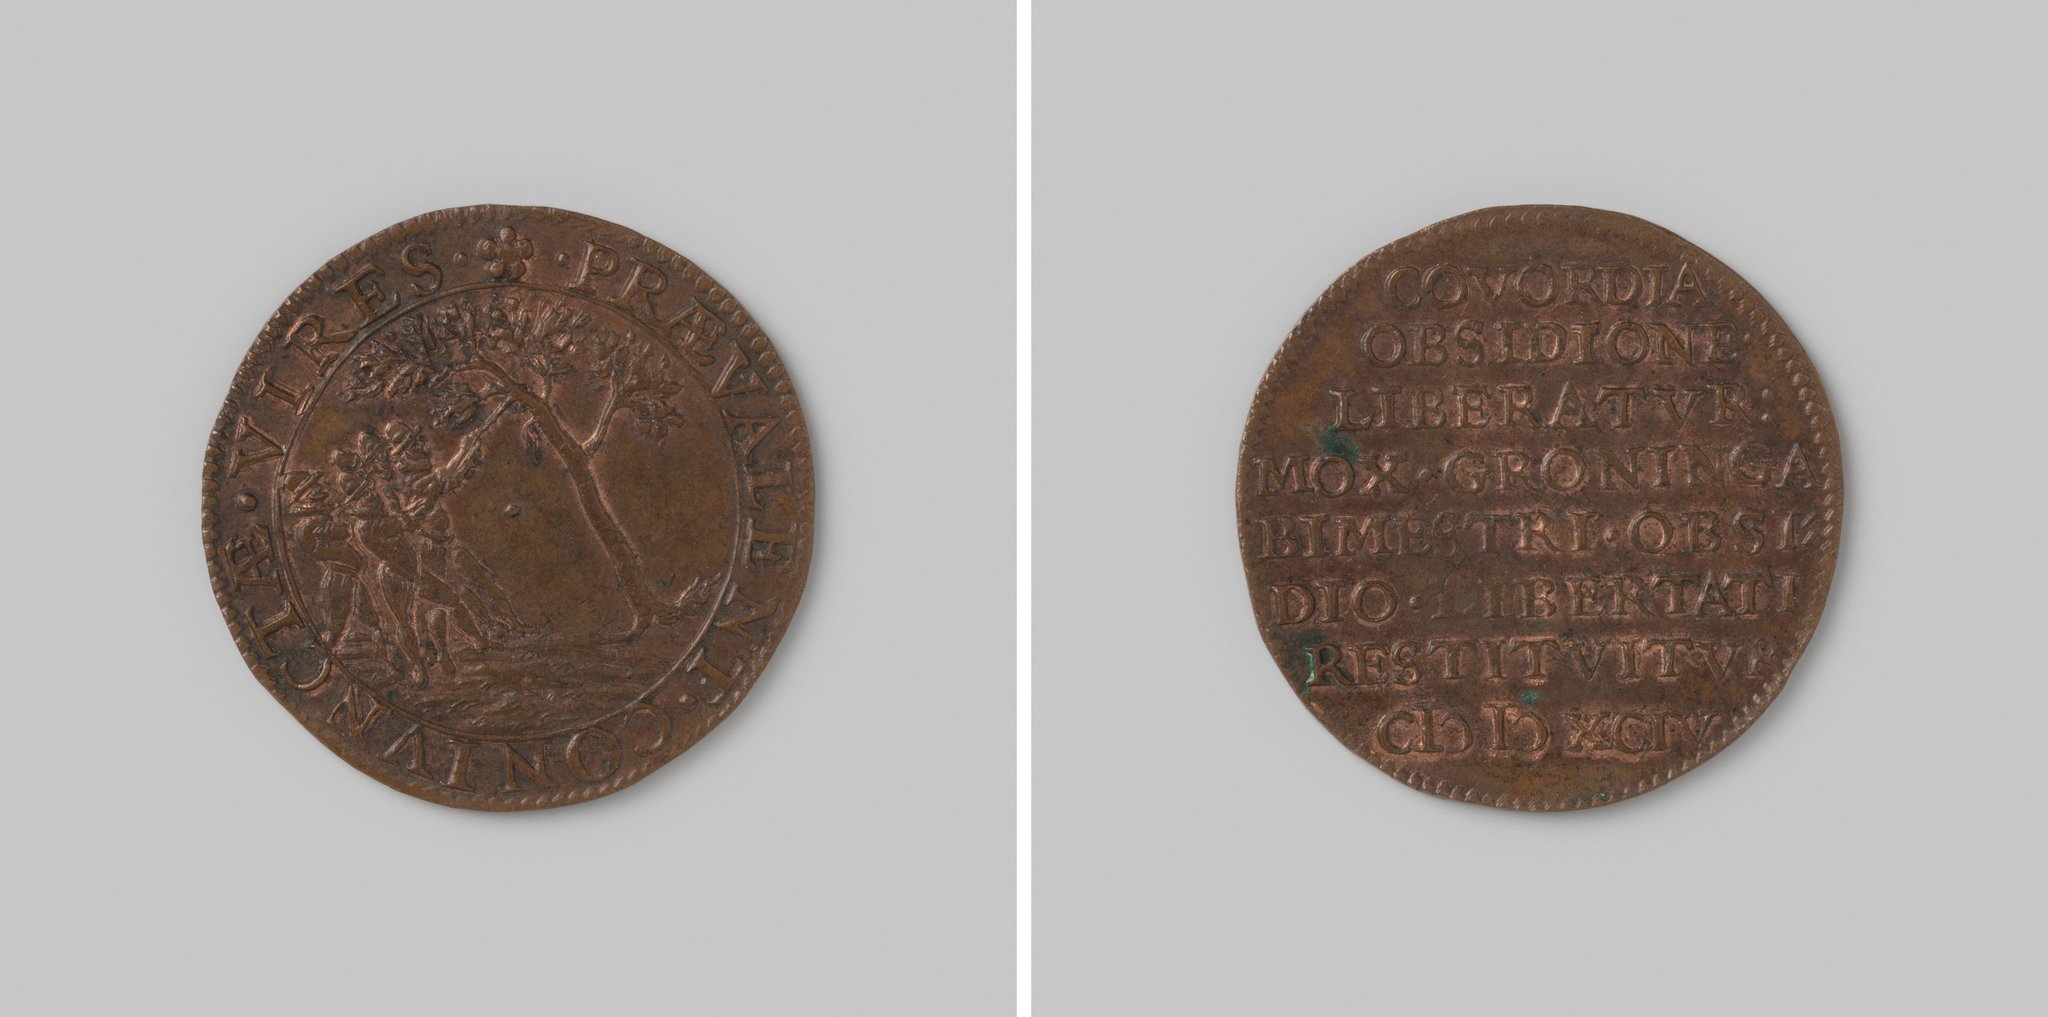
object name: history medal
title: Rekenpenning uit Dordrecht op het ontzet van Koevorden en de inname van Groningen 1594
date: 1594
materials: copper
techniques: striking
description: Koperen penning, op de voorzijde soldaten die een boom omvertrekken, met omschrift, op de keerzijde acht regels tekst, met omschrift.